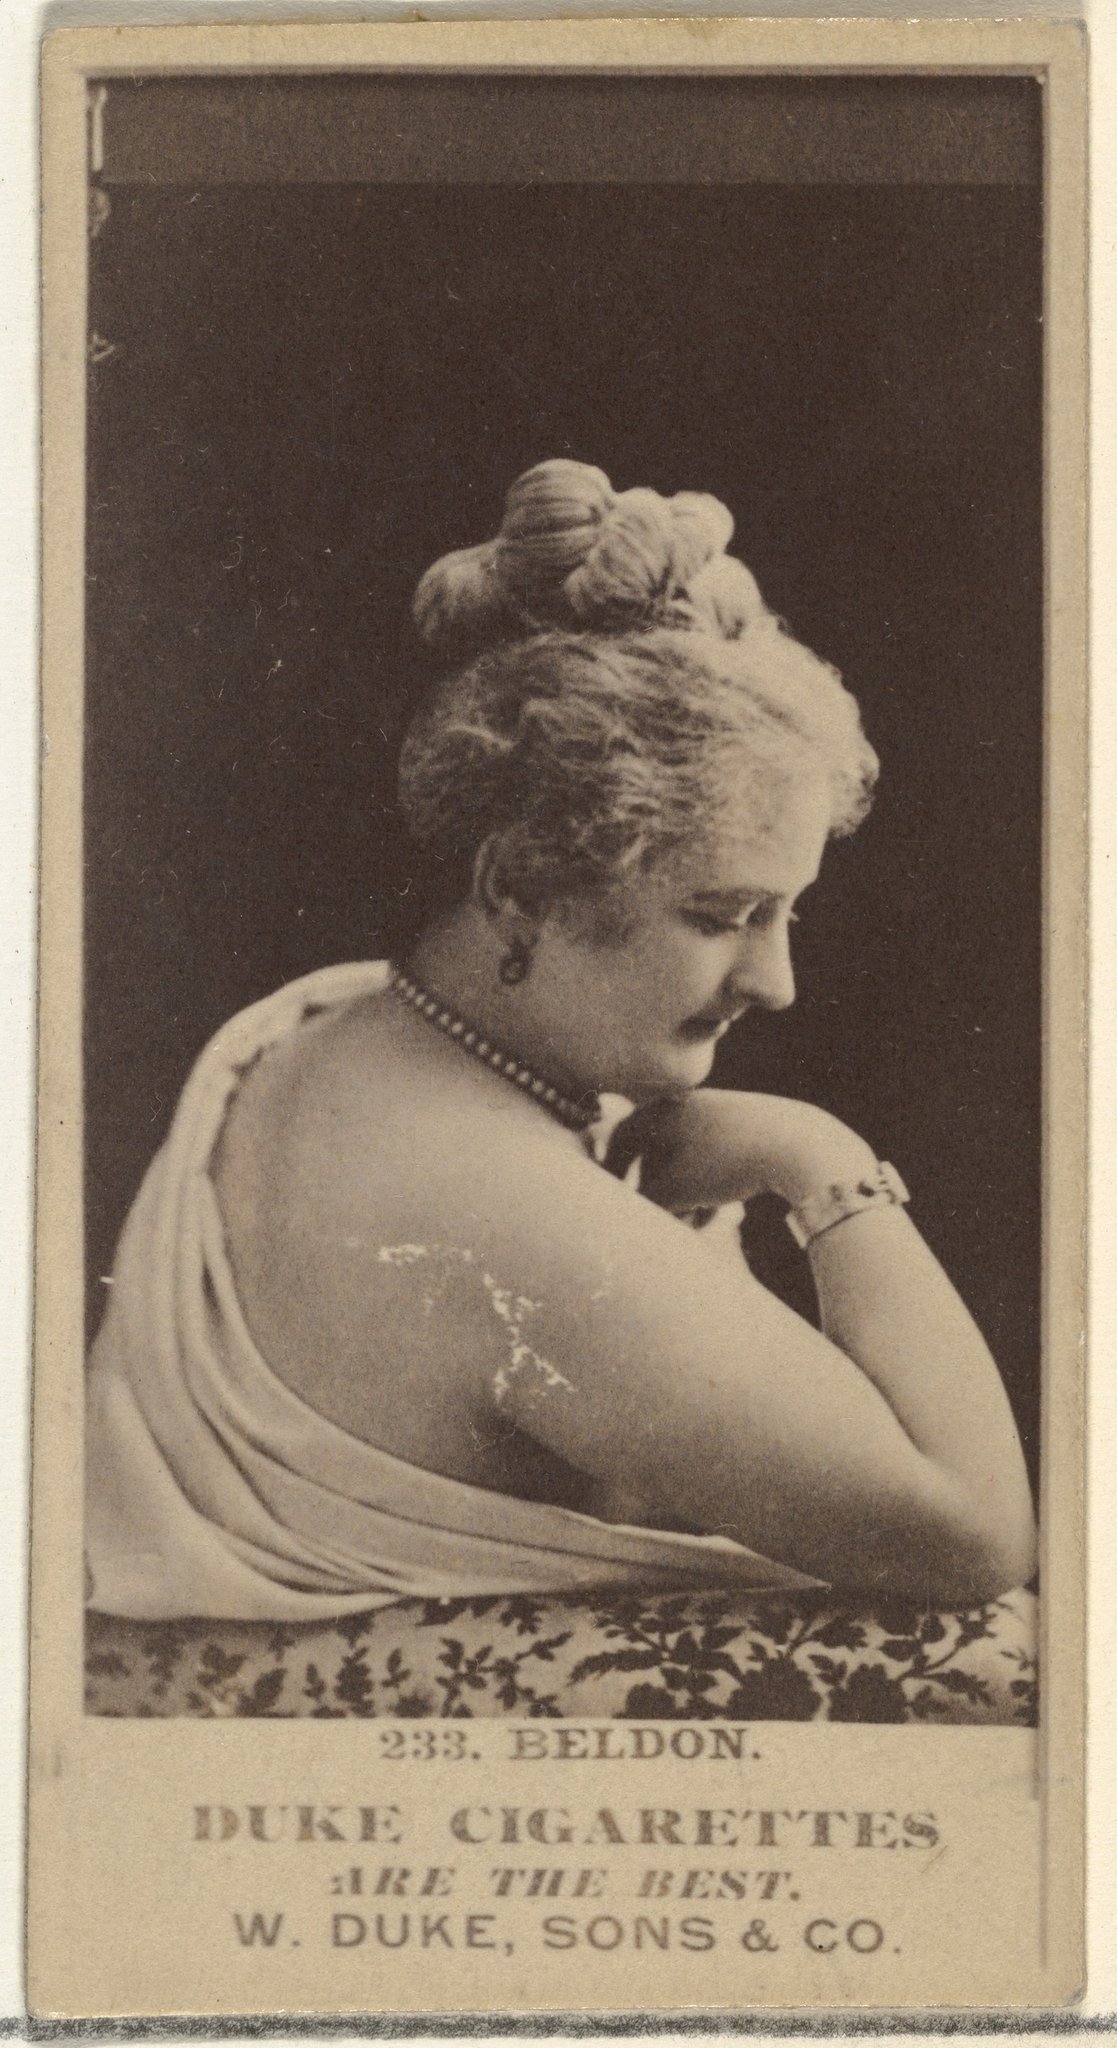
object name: photograph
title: Card Number 233, Miss Beldon, from the Actors and Actresses series (N145-7) issued by Duke Sons & Co. to promote Duke Cigarettes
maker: w. duke, sons & co.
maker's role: publisher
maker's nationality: american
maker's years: 1870-1920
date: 1880-1889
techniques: albumen silver print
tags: women,actresses